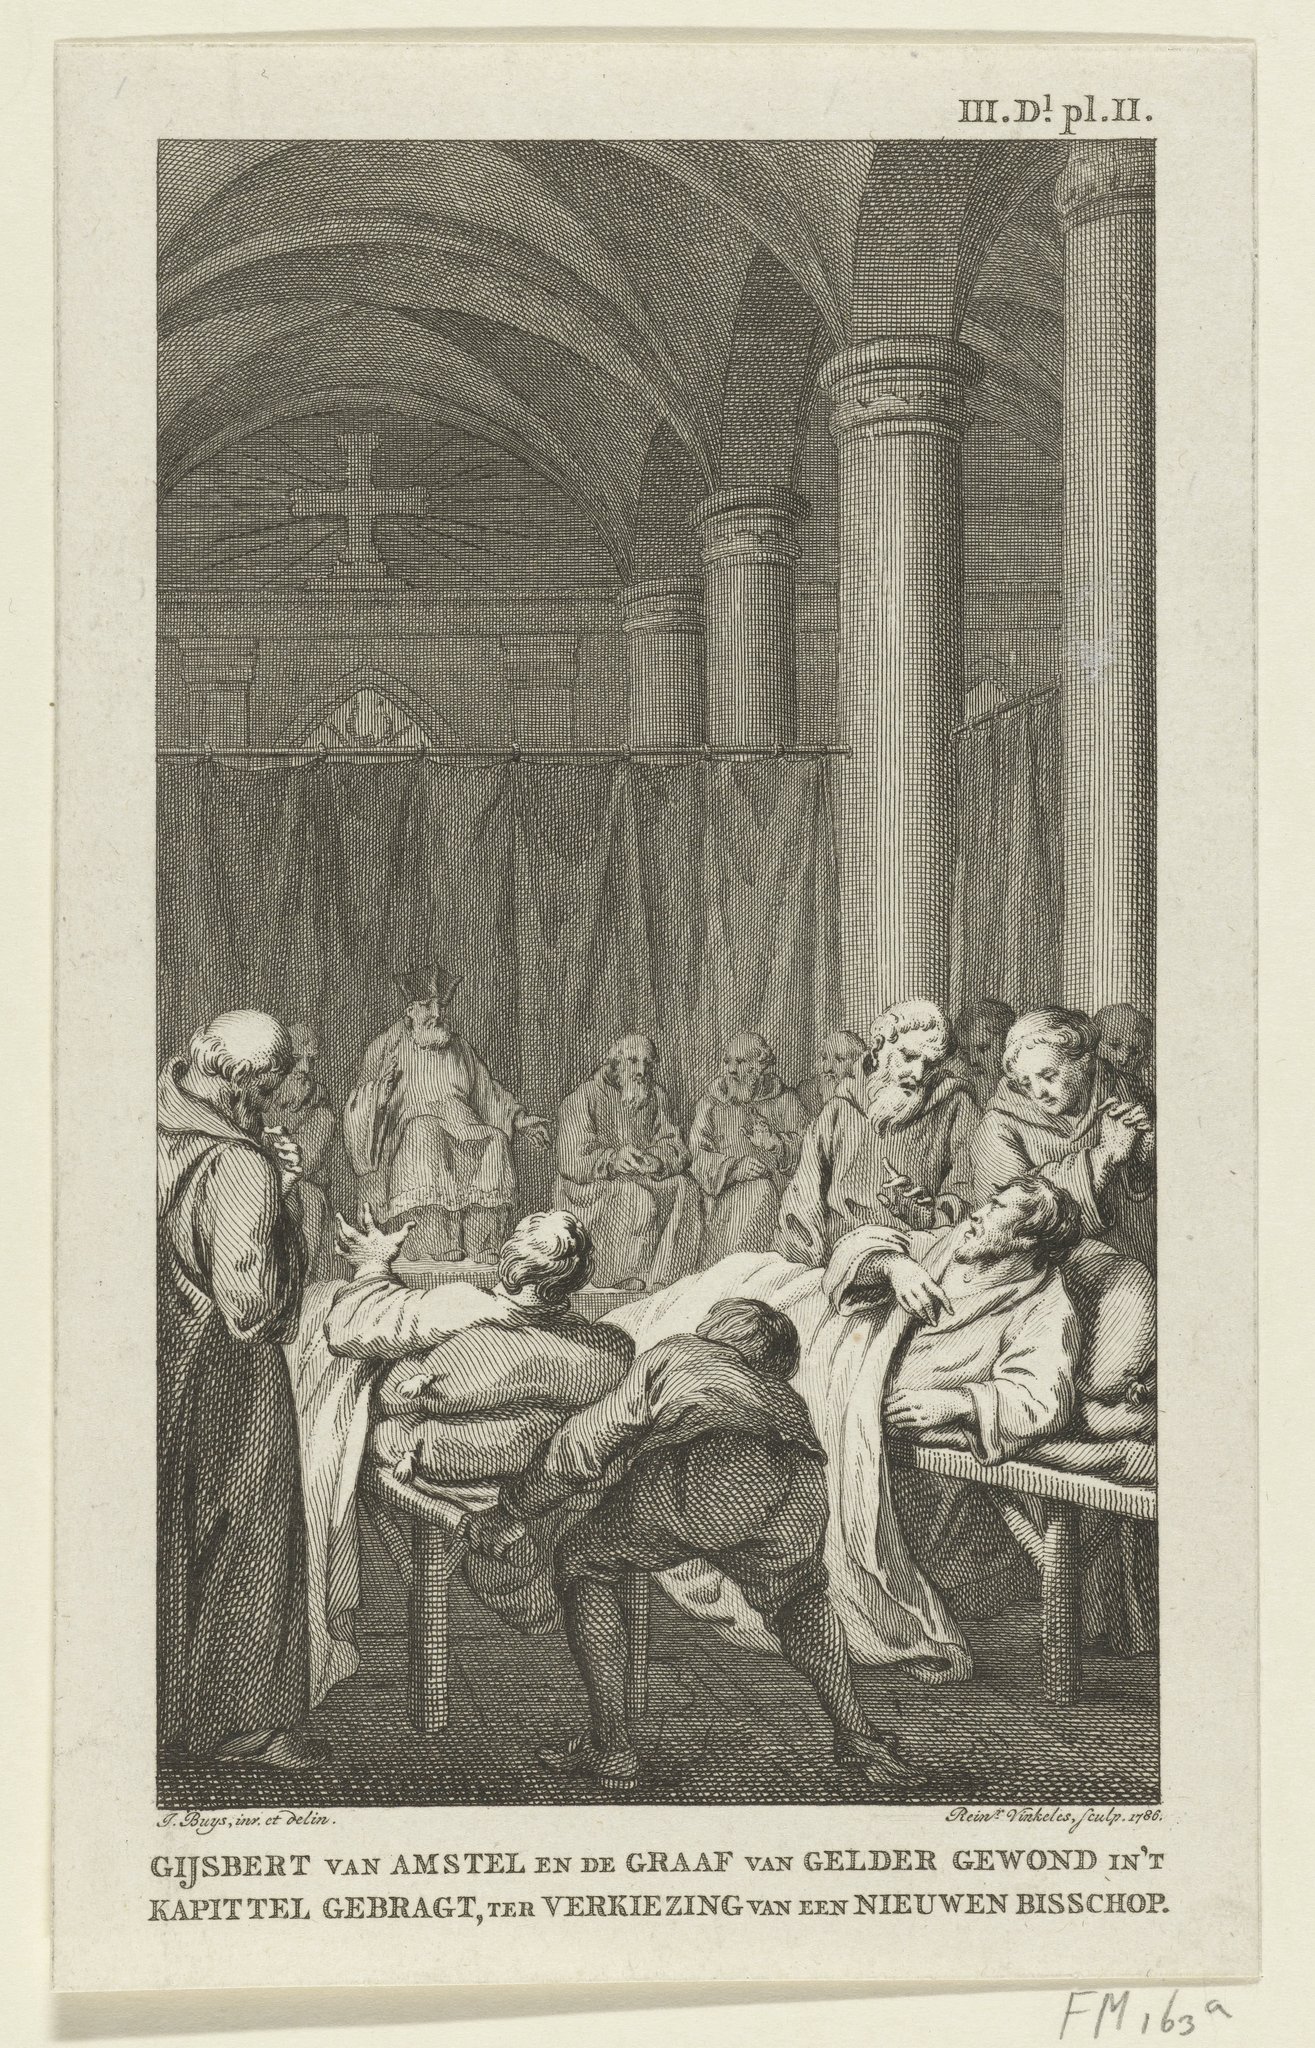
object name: history print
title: Gijsbert van Amstel en de Graaf van Gelder gewond in't kapittel gebragt, ter verkiezing van een nieuwen bisschop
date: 1786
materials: paper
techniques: etching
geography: netherlands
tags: archbishop, bishop, etc. (roman catholic), netherlands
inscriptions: date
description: Gijsbrecht II (of Gijsbert) van Amstel en de graaf van Gelder, gewond geraakt tijdens de Slag bij Ane op 27 juli 1227, worden liggend op brancards naar het kapittel gebracht om hun stem uit te brengen bij de verkiezing van een nieuwe bisschop als opvolger voor de bij de slag gedode bisschop Otto II.